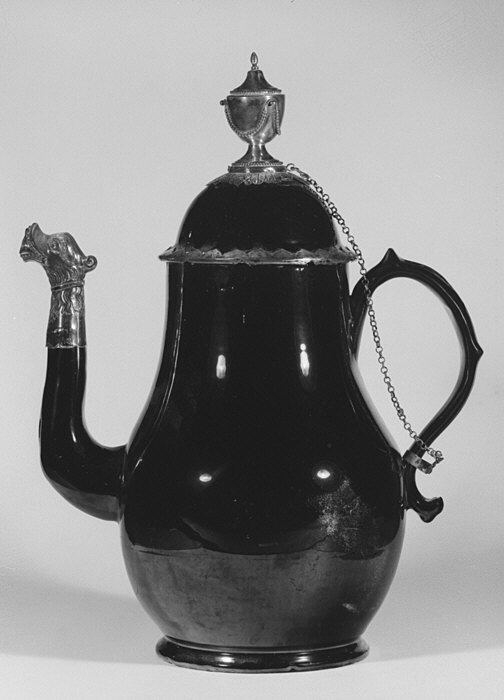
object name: tea and coffee set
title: Tea and coffee set (teapot, coffeepot, milk jug, sugar bowl)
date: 1801-1833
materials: earthenware, silver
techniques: glazing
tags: animals